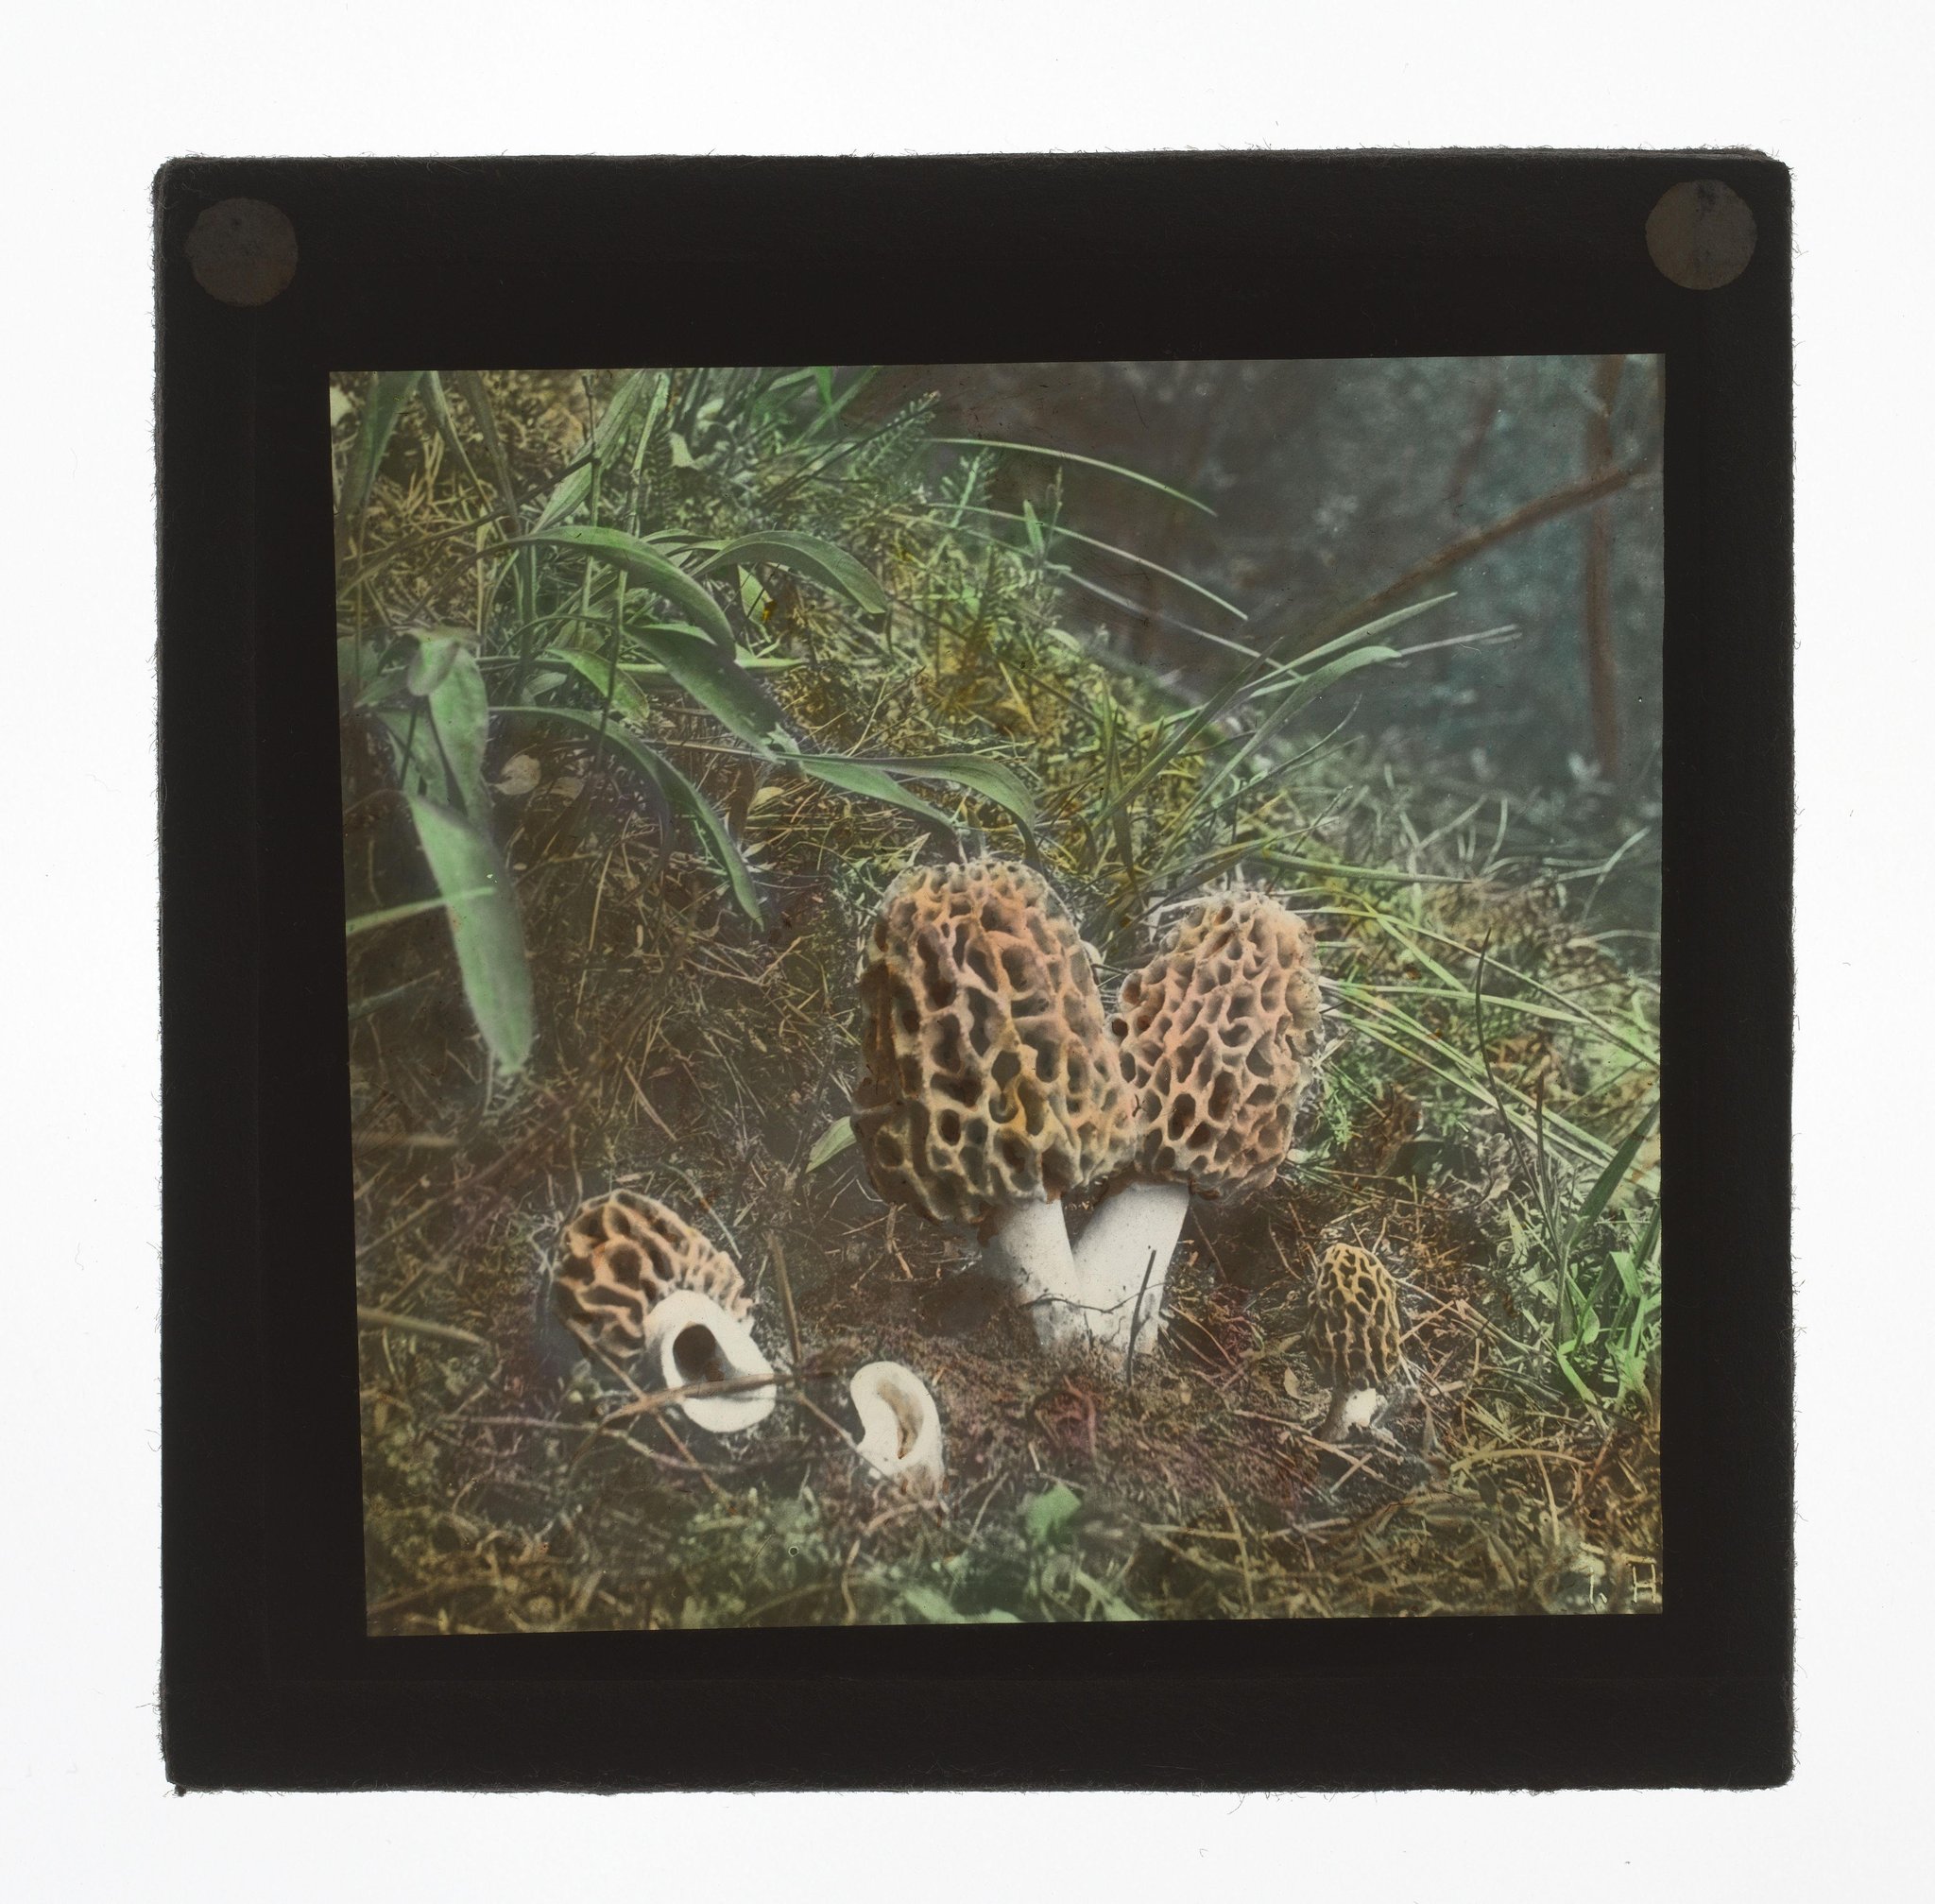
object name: photograph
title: Paddenstoelen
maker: Anonymous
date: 1900-1930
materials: glass, paper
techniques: slide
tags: mushrooms